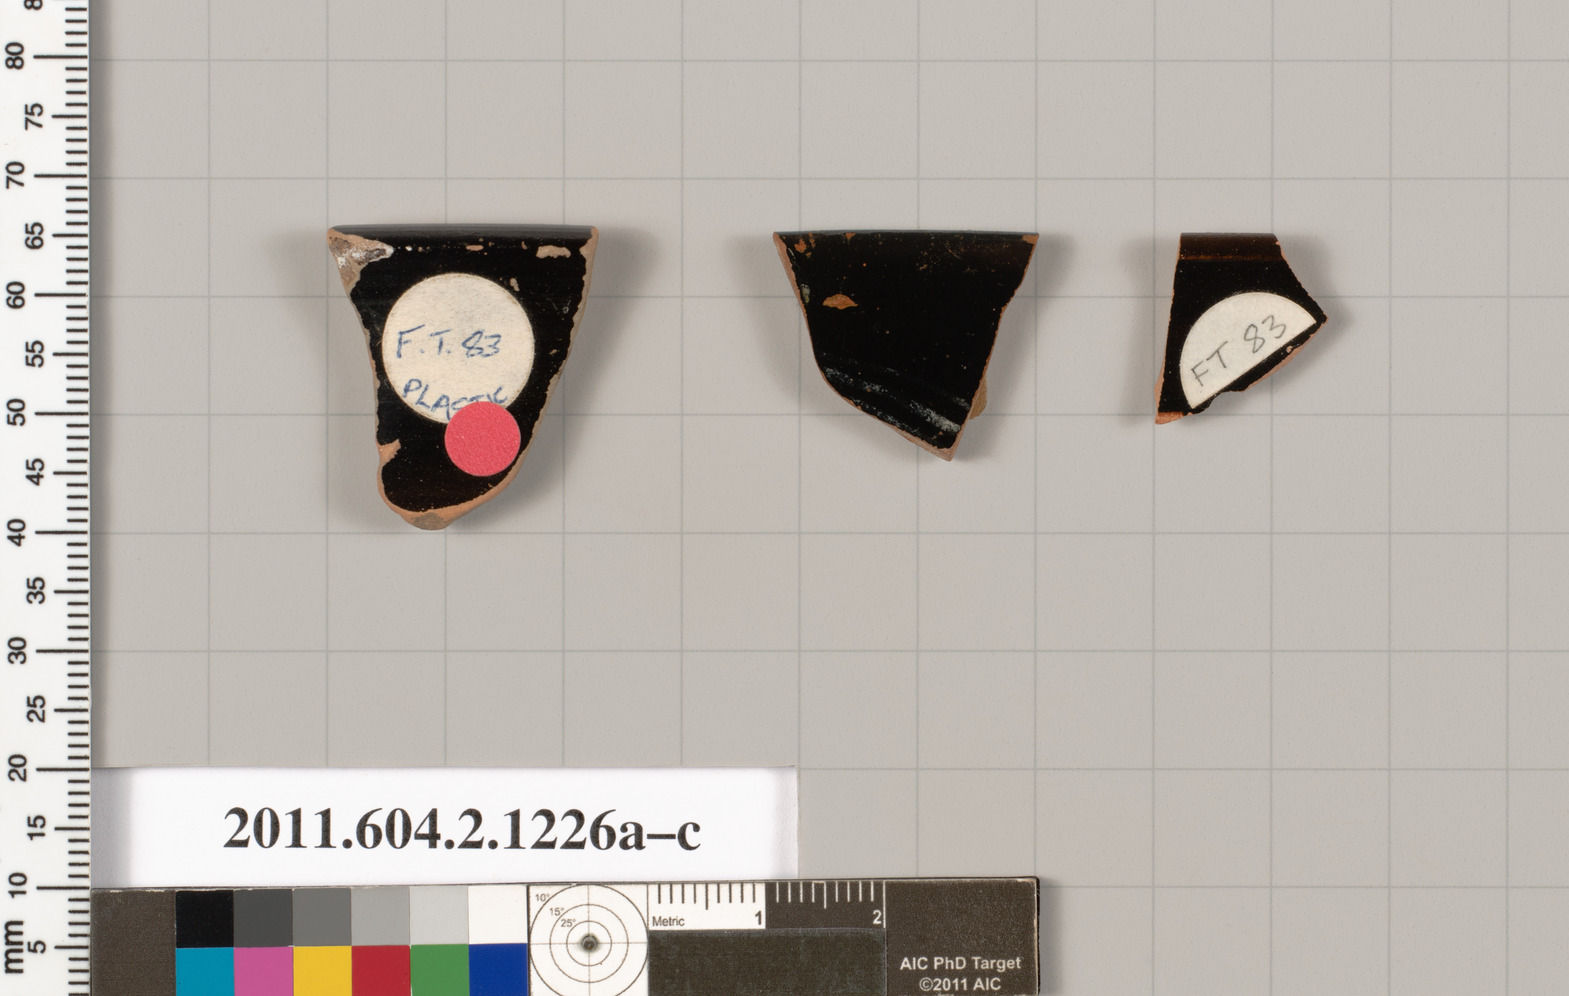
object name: kantharos fragment, head vase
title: Terracotta fragments from kantharoi: head vases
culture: greek, attic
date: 475-451 BCE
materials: terracotta